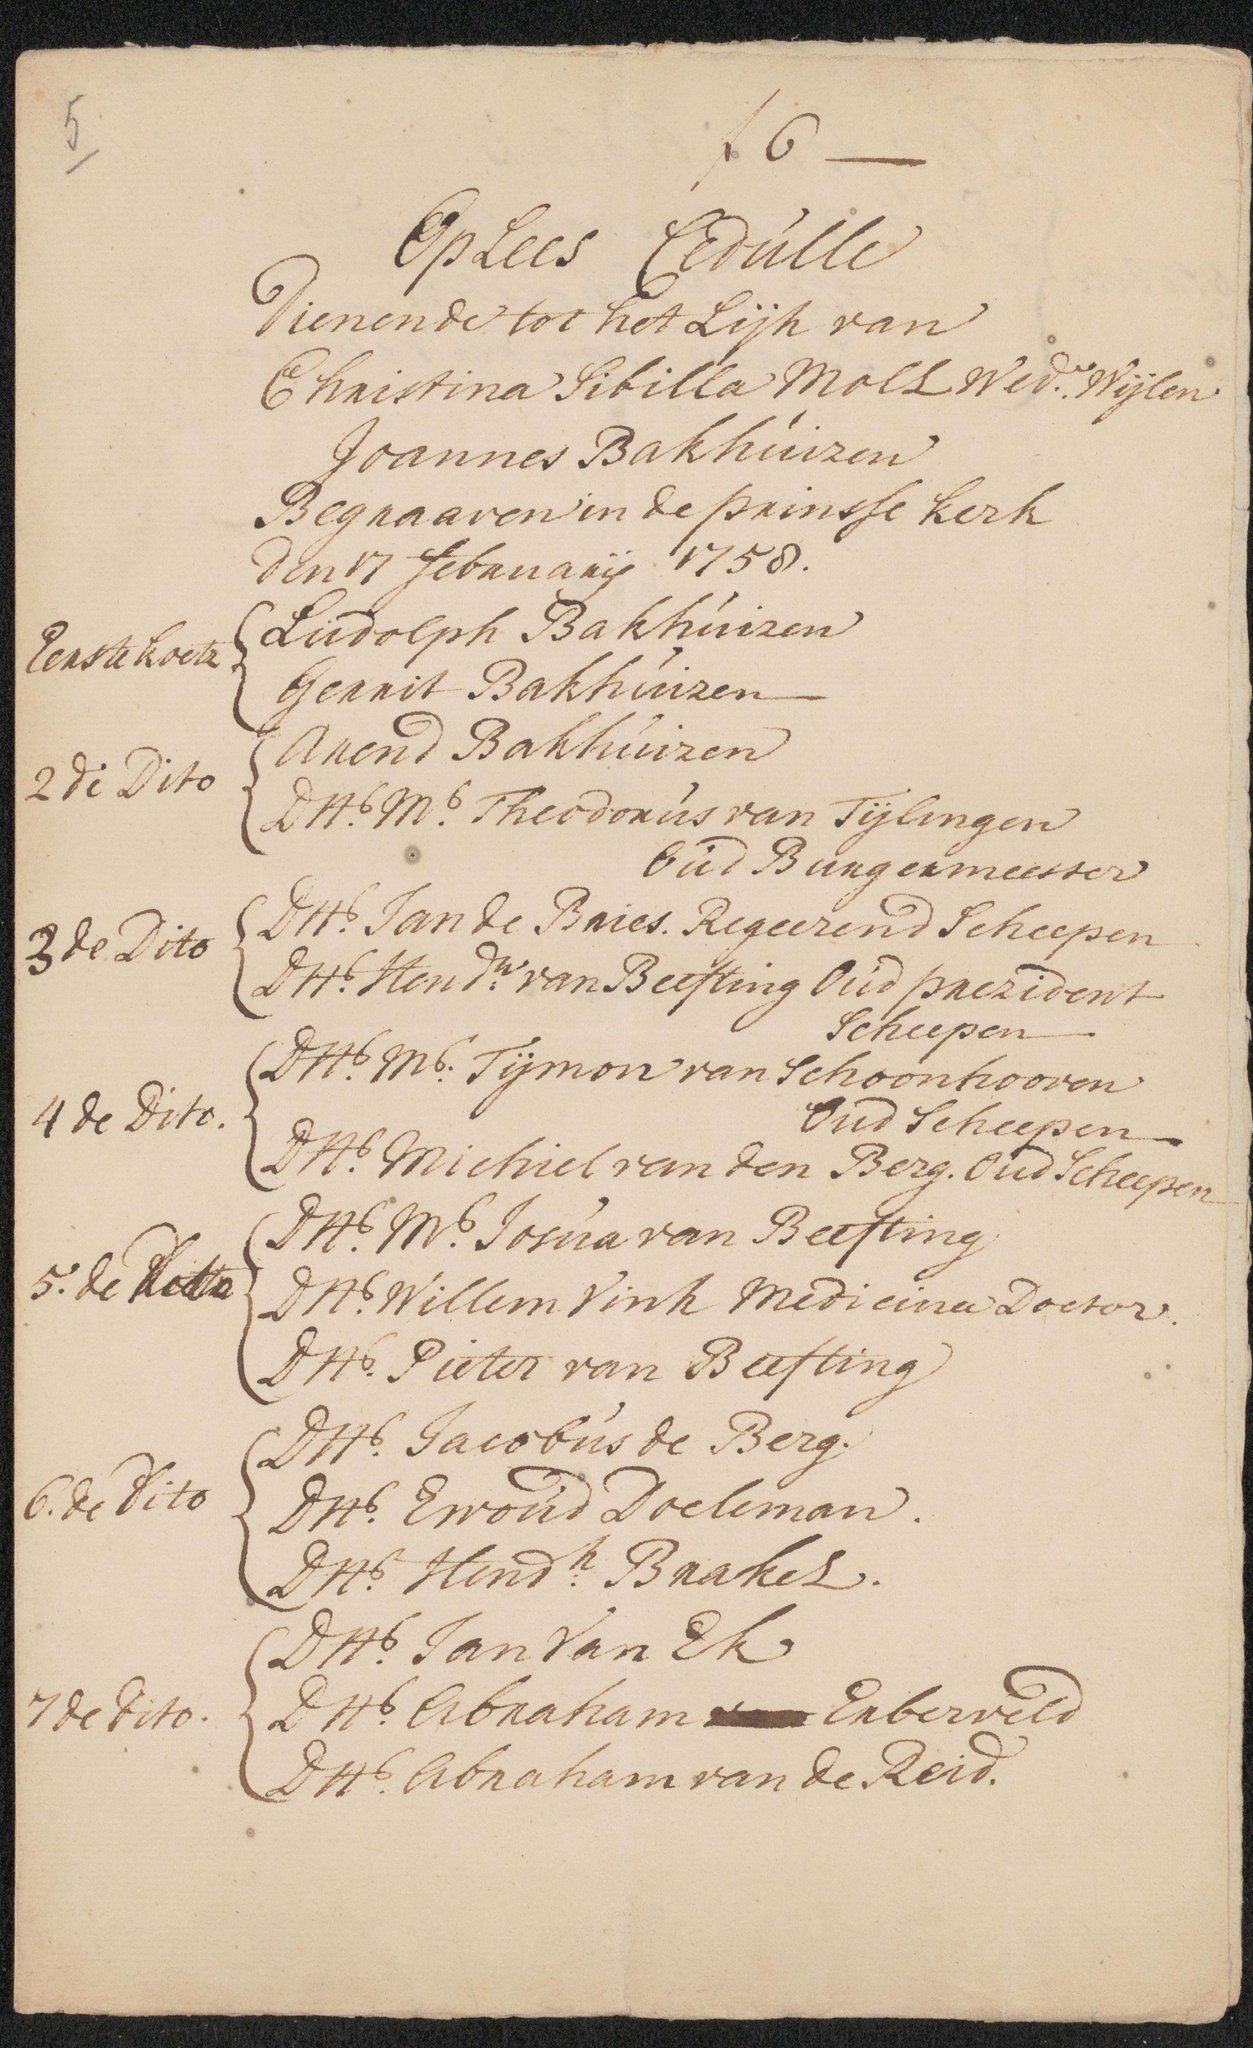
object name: manuscript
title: Handschrift betreffende Christina Sibilla Bakhuysen-Moll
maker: Anonymous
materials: ink, paper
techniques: pen, writing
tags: johannes bakhuysen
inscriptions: watermark, collector's mark: Lugt 2233